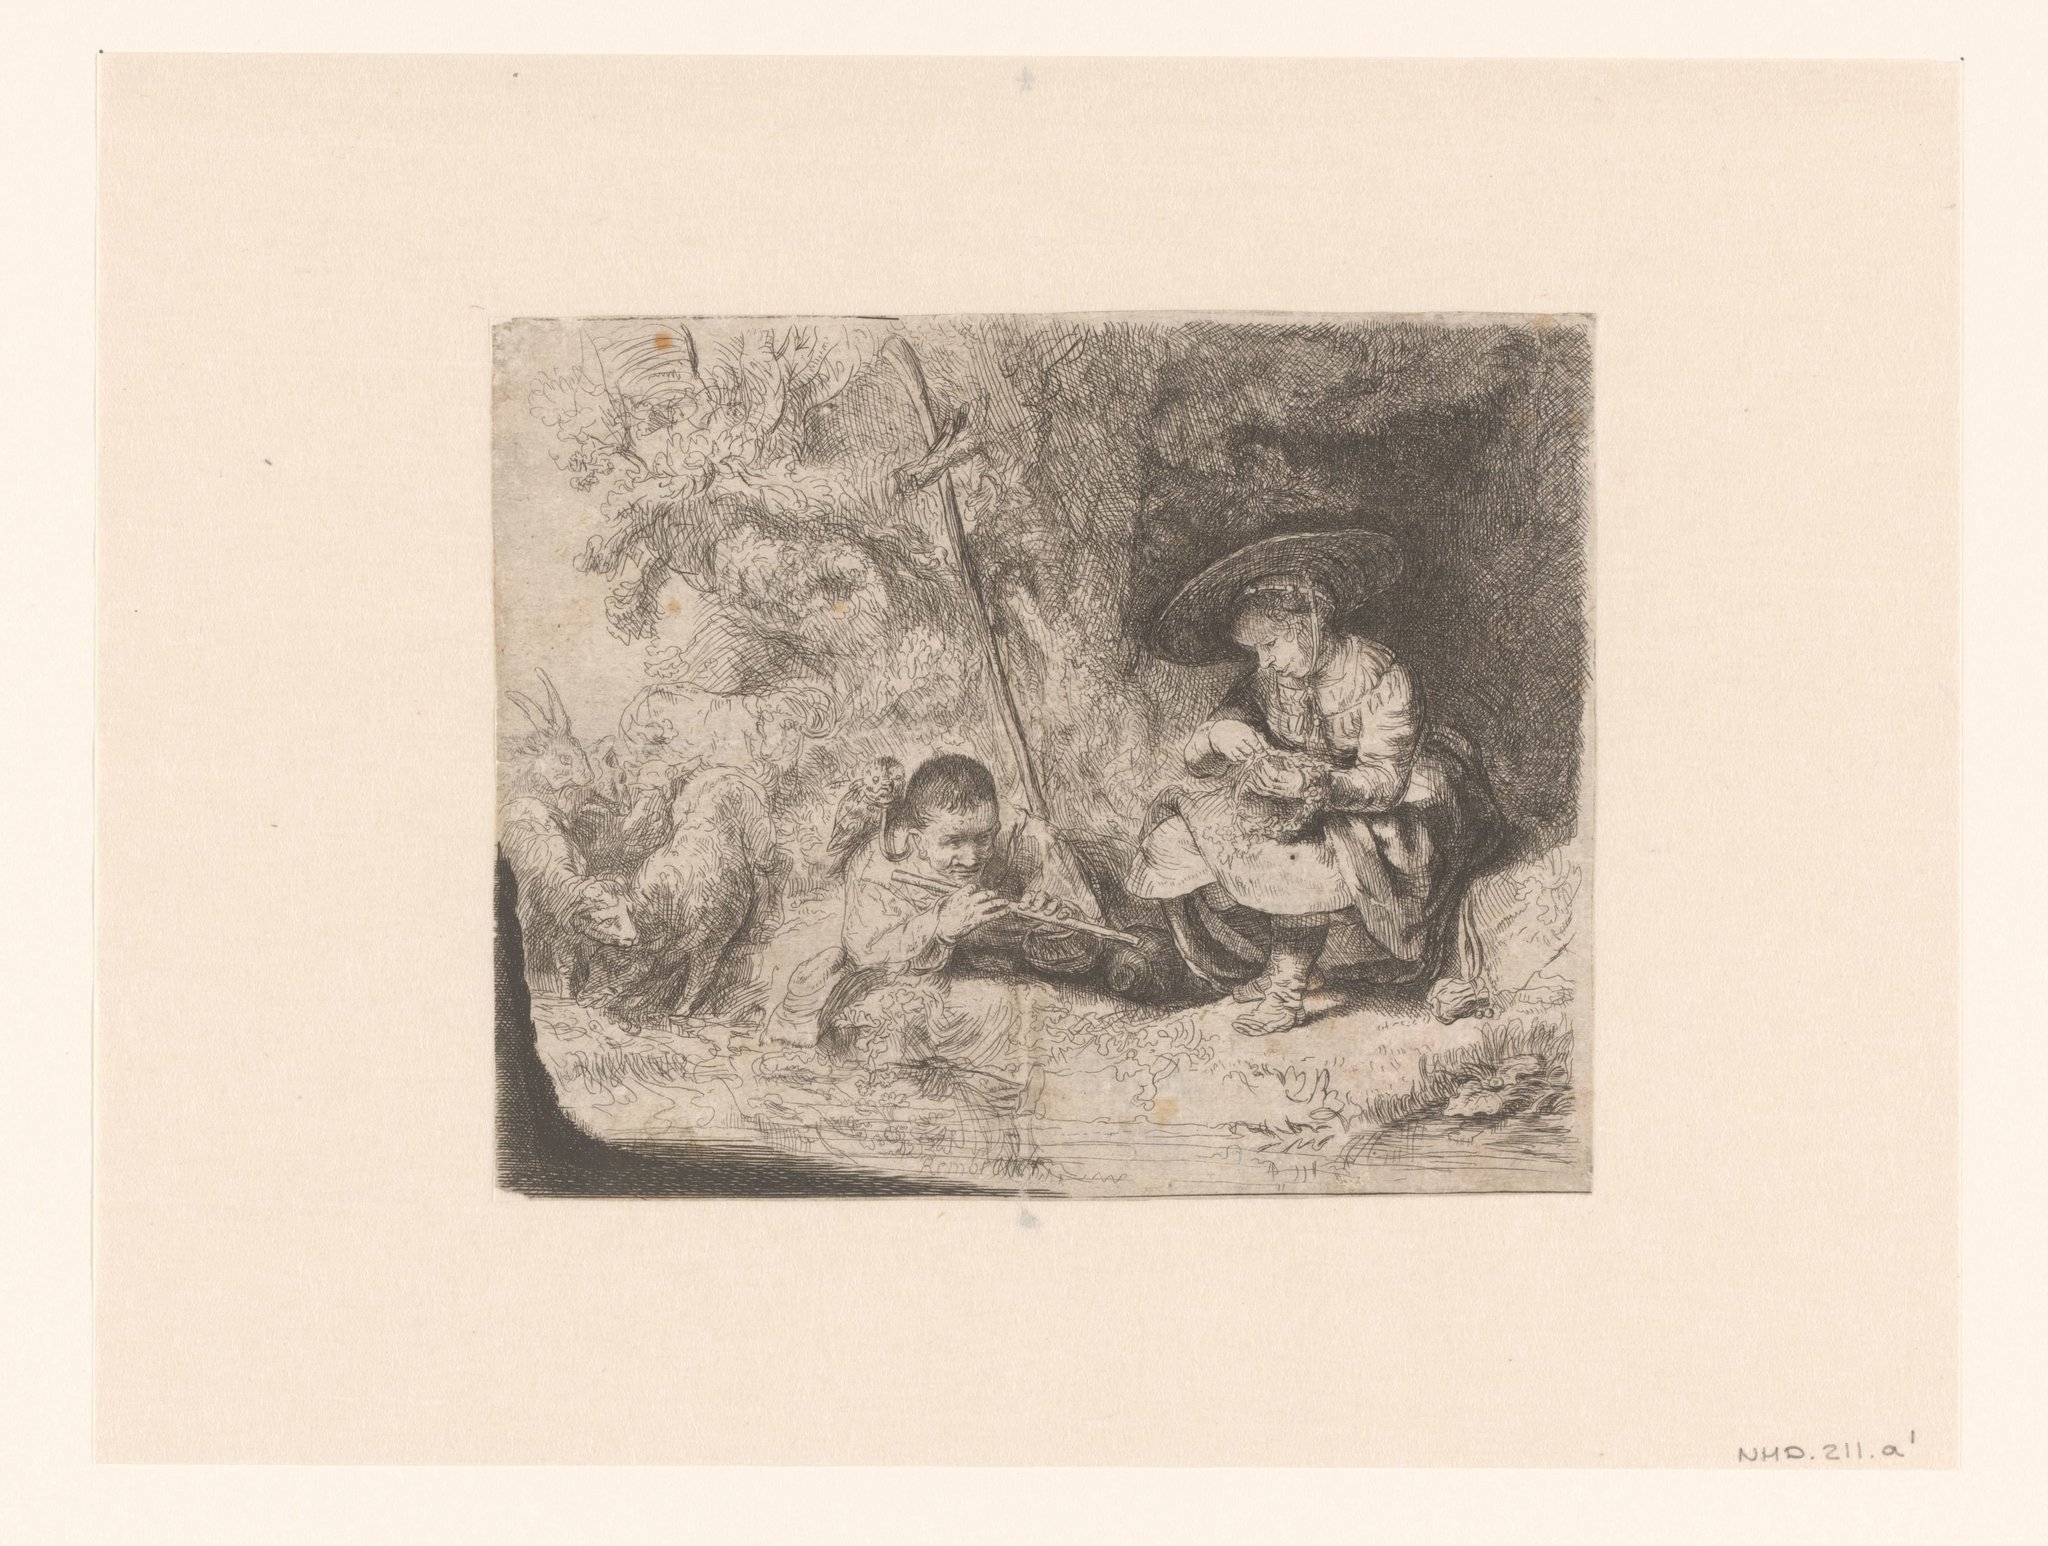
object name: print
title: The flute player ('Het Uilenspiegeltje')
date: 1642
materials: paper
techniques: etching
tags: flute, aulos, tibia - cc - out of doors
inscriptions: collector's mark: Lugt 240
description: Spiegelbeeldige kopie naar de gelijknamige prent van Rembrandt.